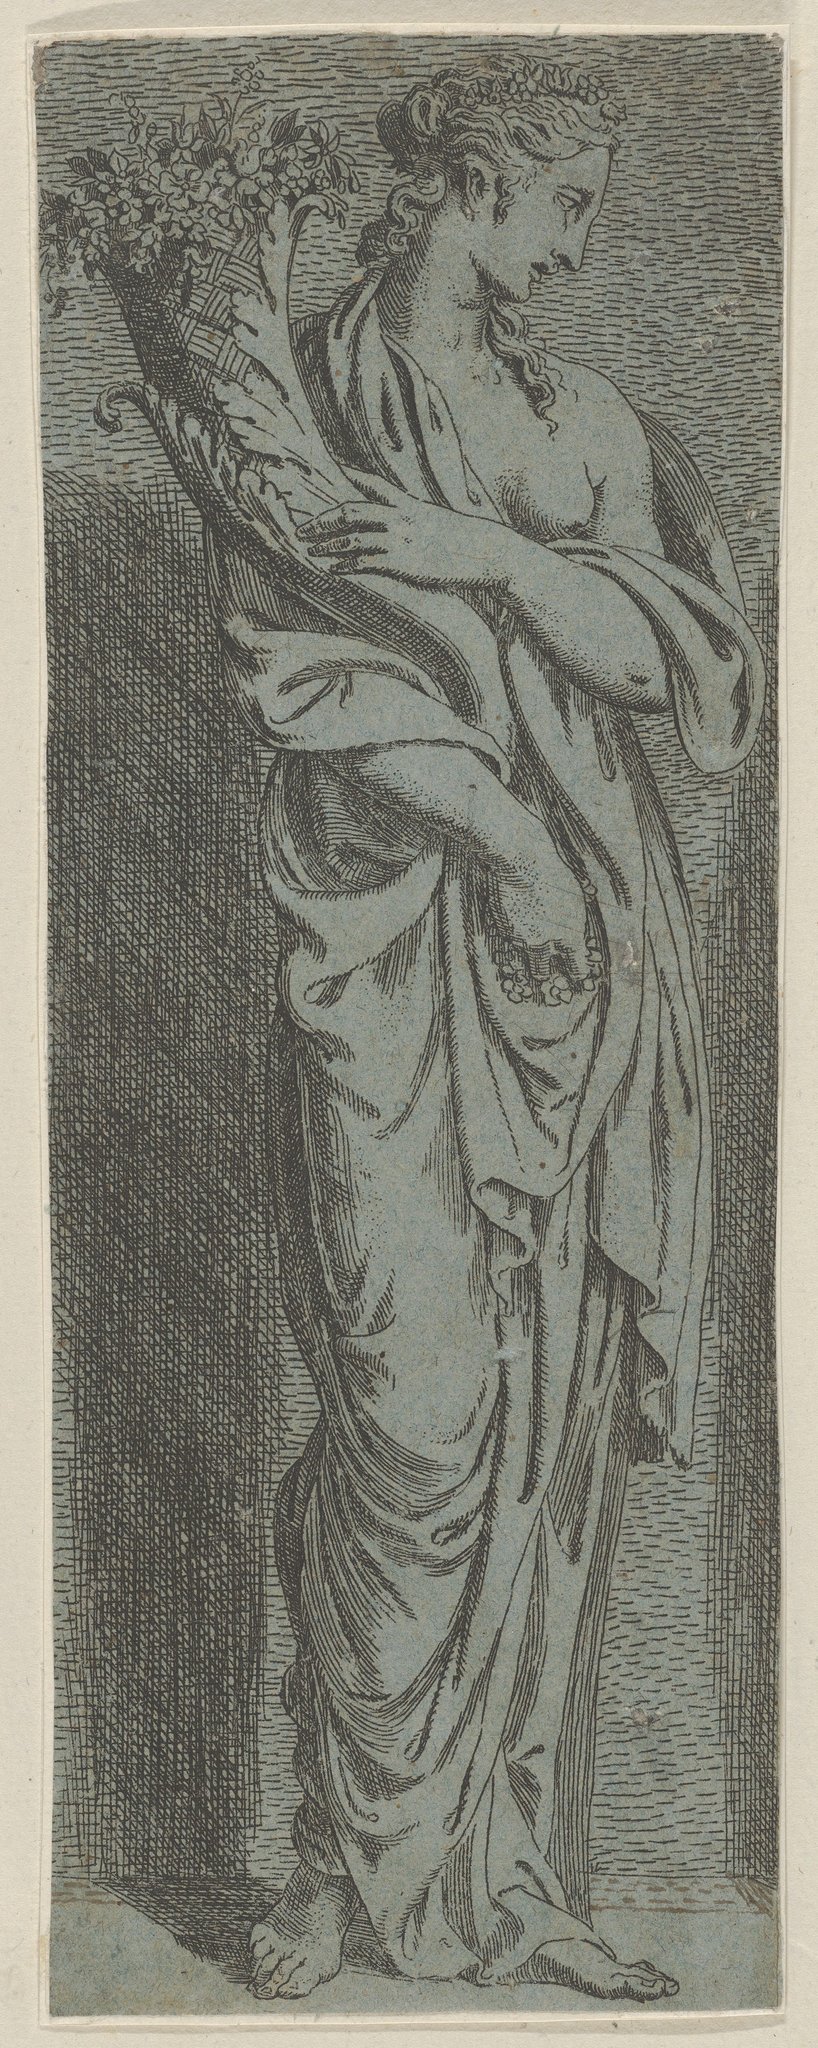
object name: print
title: Spring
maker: battista angolo del moro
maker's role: artist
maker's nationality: italian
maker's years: 1515-1573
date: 1530-1573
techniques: etching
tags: profiles,women